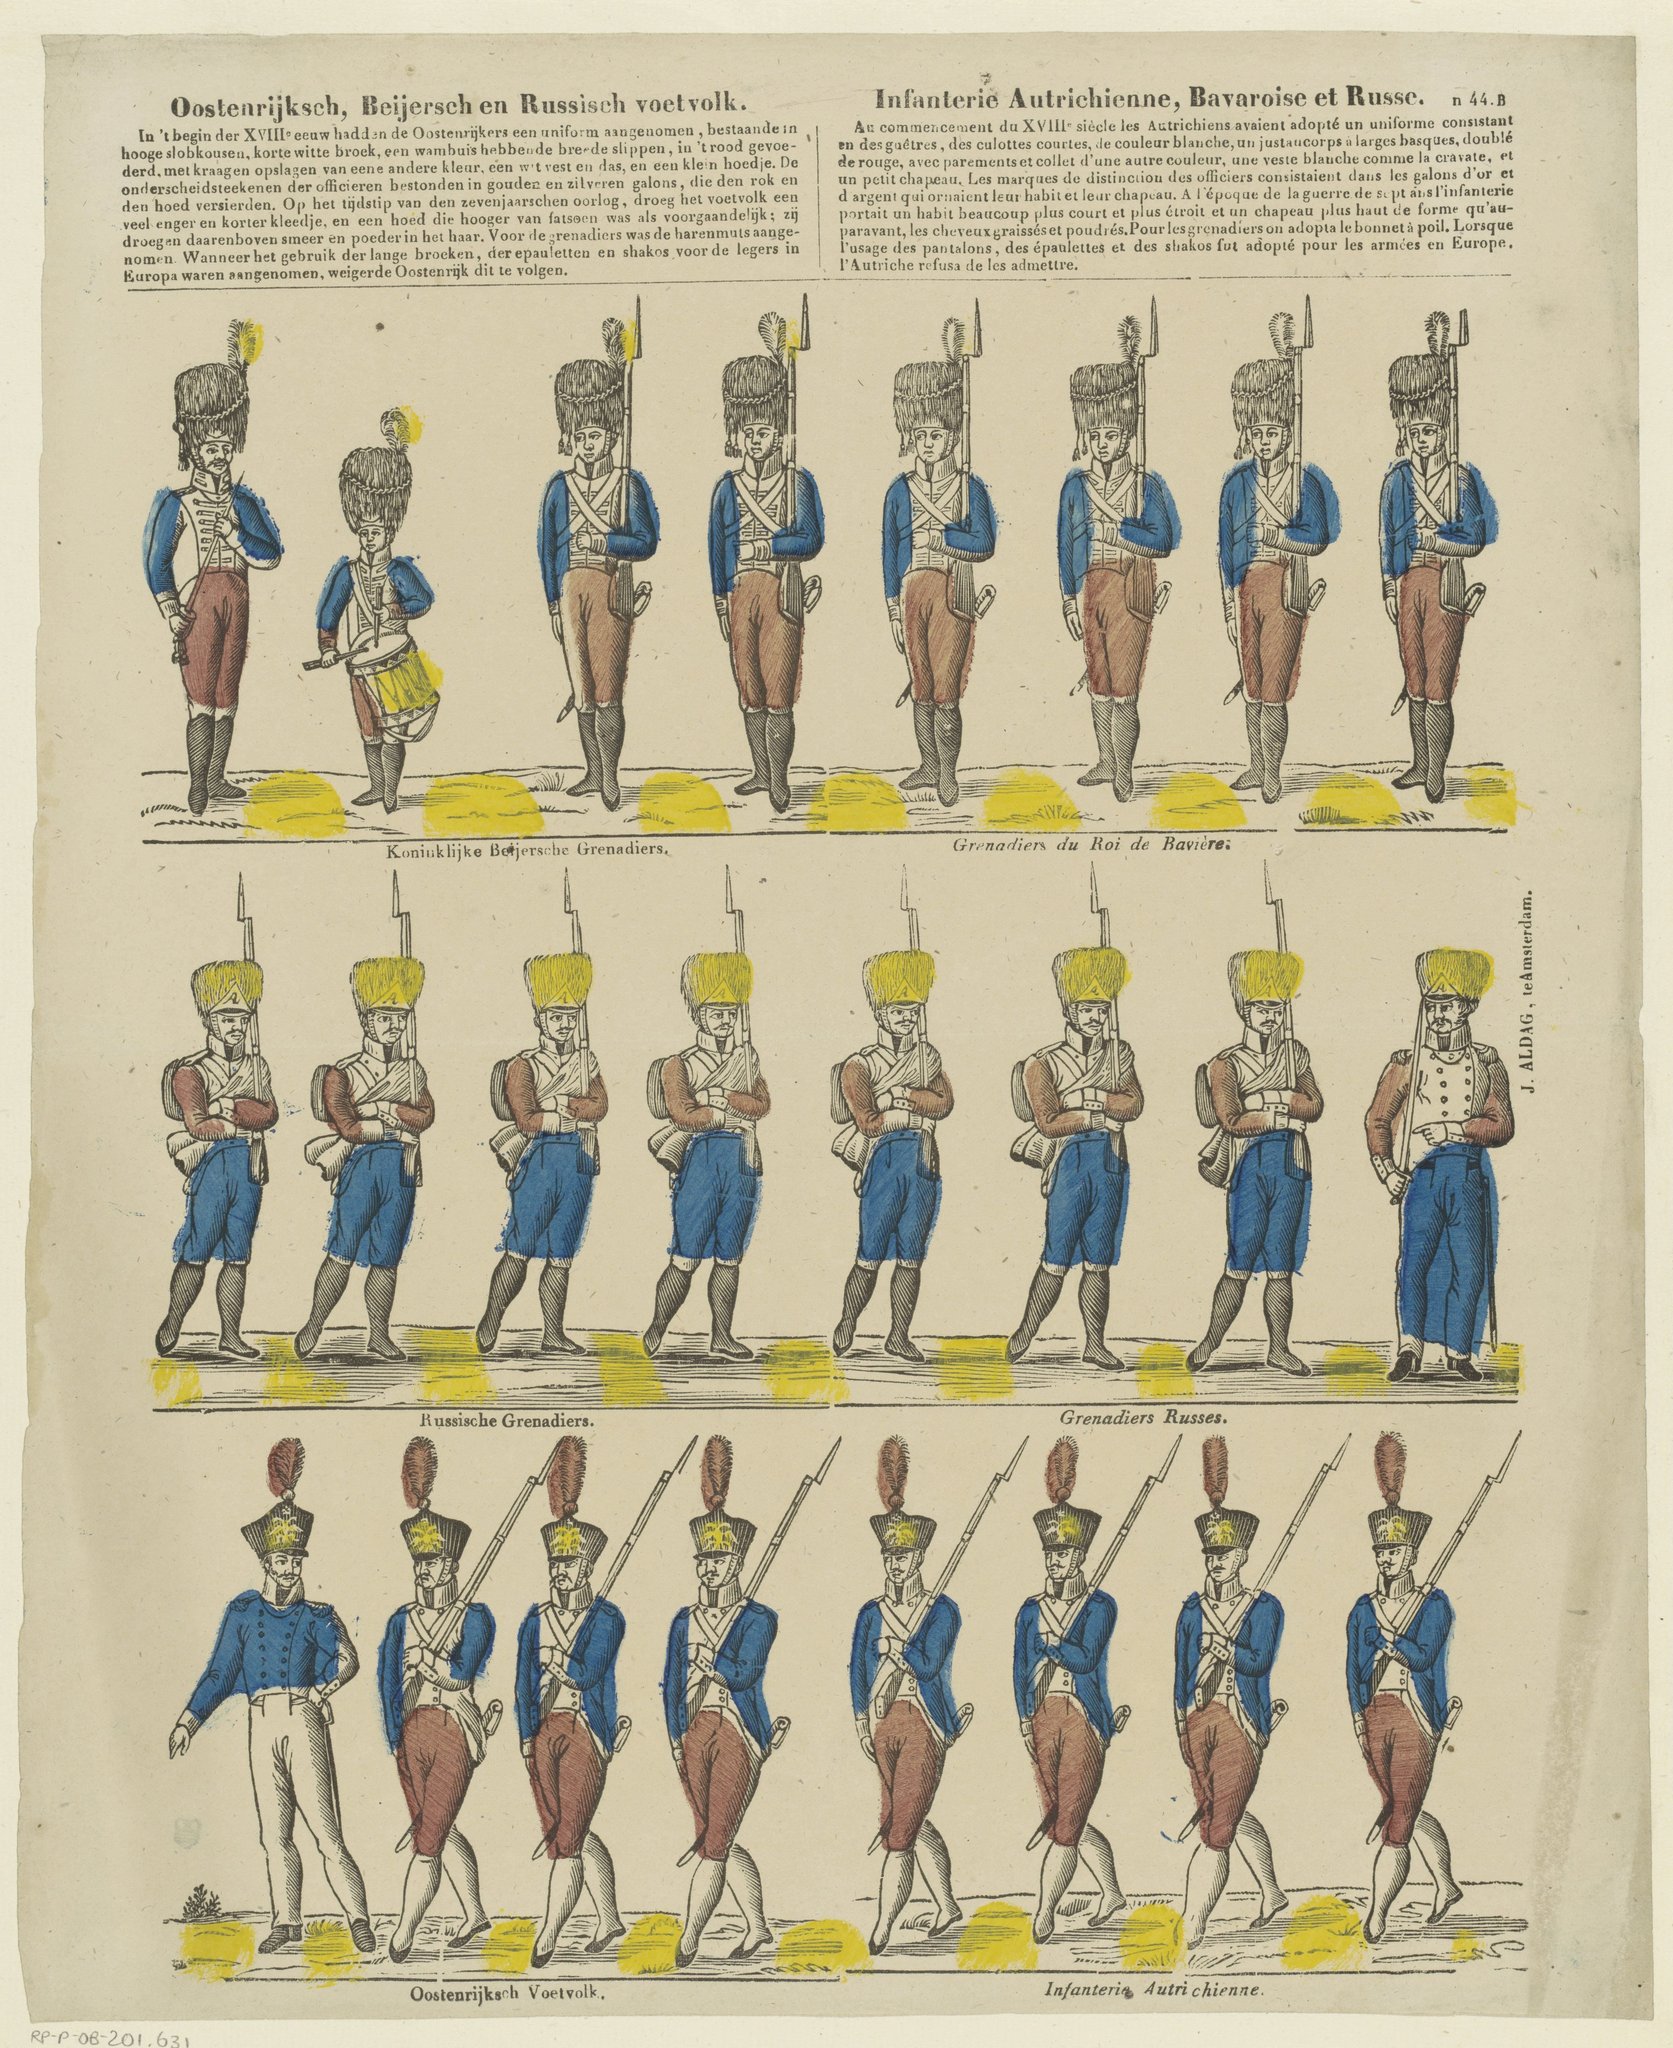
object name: print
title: Oostenrijksch, Beijersch en Russisch voetvolk / Infanterie Autrichienne, Bavaroise et Russe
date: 1800-1833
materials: paper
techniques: colour, letterpress printing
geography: turnhout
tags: the soldier; the soldier's life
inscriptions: collector's mark: Lugt 2760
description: Blad met 3 horizontale rijen met elk acht militairen op een rij. Op de bovenste rij Beierse soldaten, op de middelste rij Russische soldaten en op de onderste rij Oorstenrijkse soldaten. Onder elke voorstelling een onderschrift in het Nederlands en in het Frans. Een negenregelig bovenschrift bovenschrift in twee kolommen in het Nederlands en in het Frans. Genummerd rechtsboven: n 44. B.